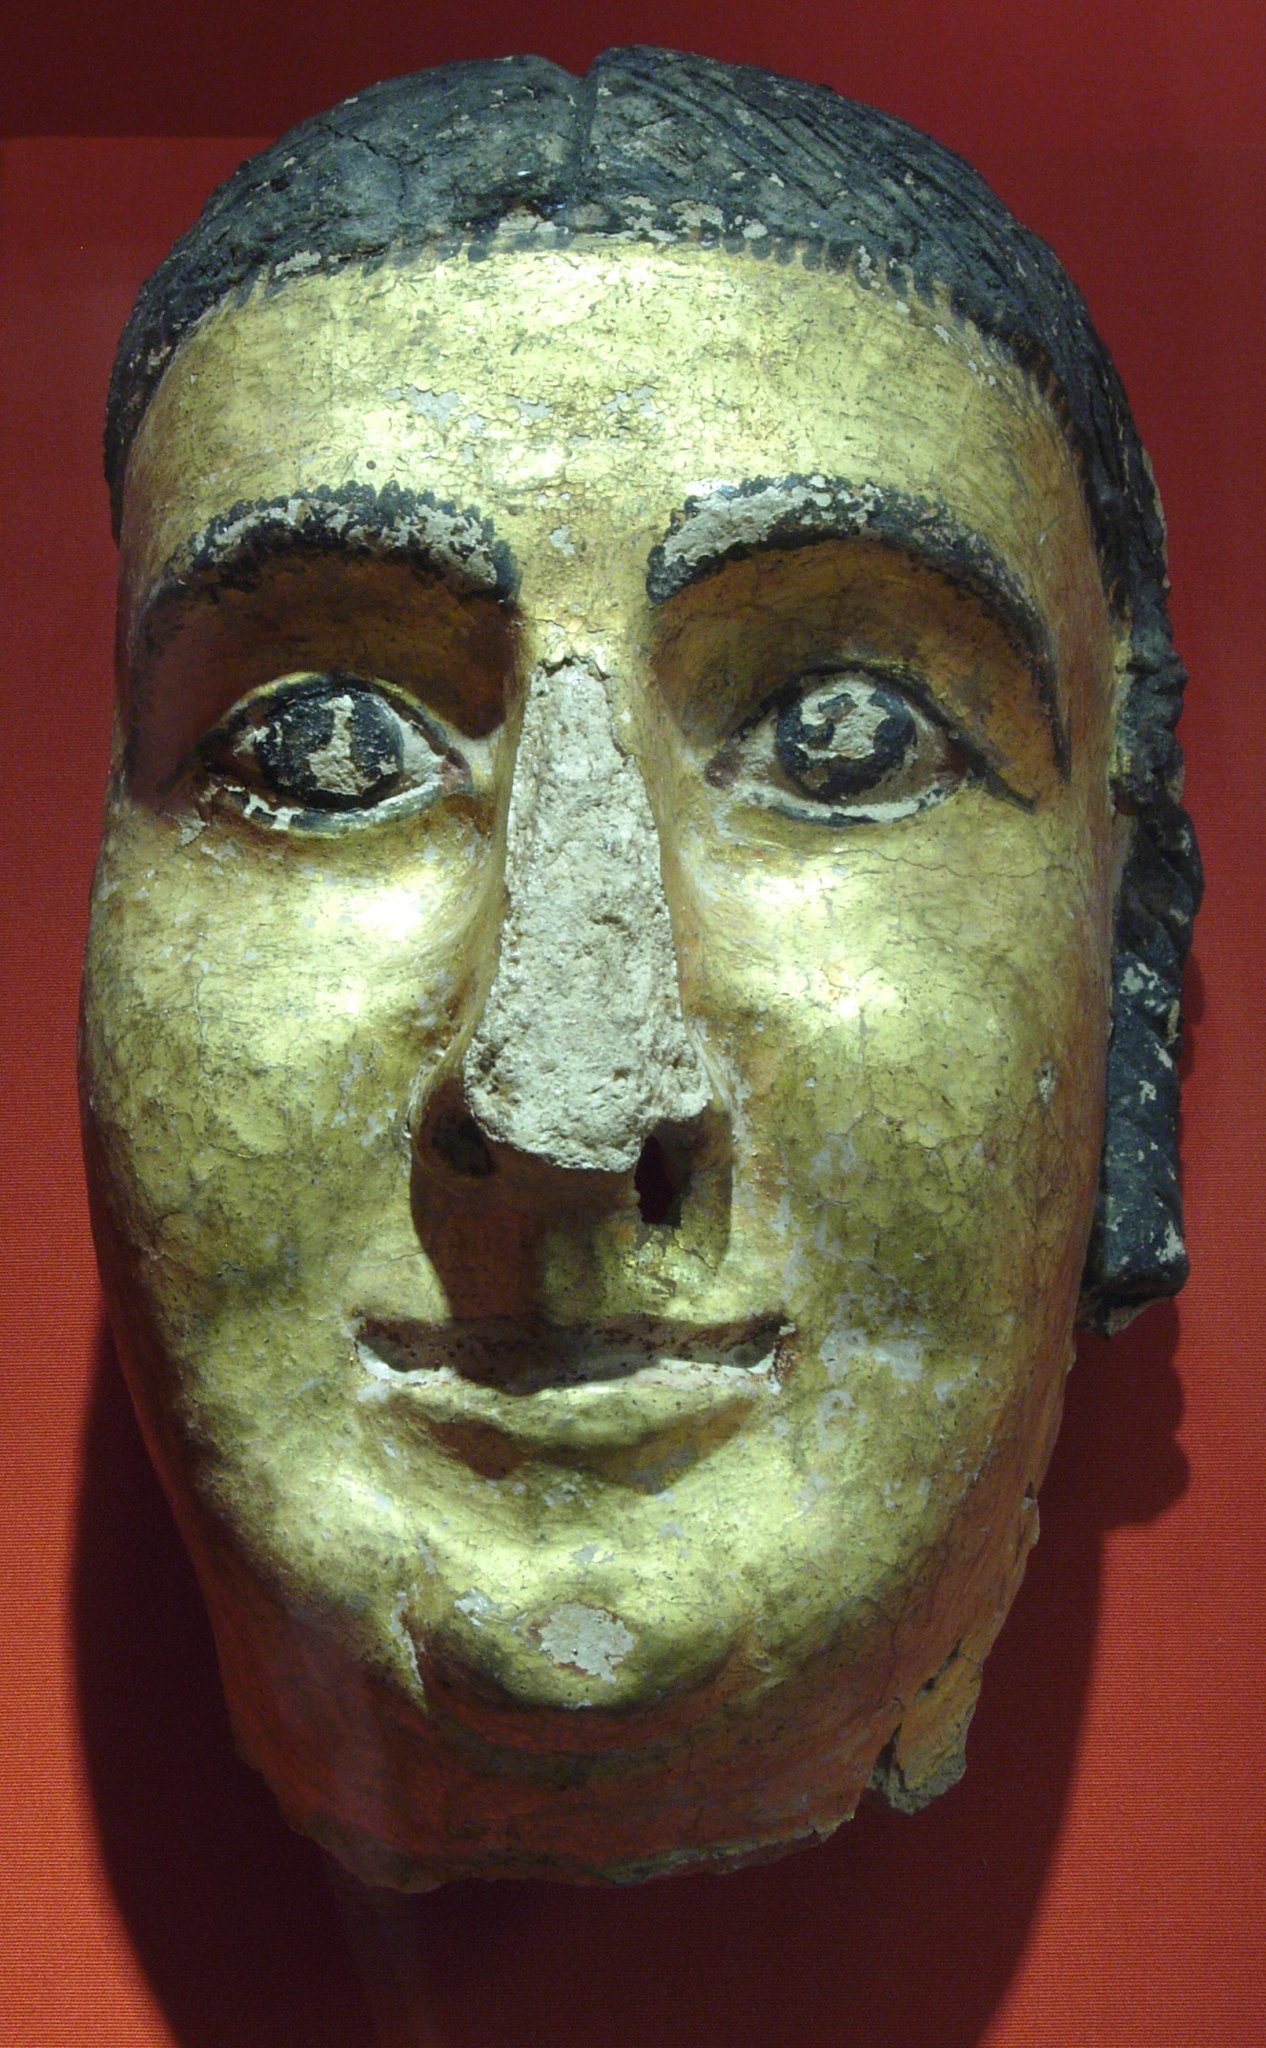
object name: mask, woman, gilding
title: Mask of a woman with cosmetic lines and gilding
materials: gold leaf, paint, plaster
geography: egypt